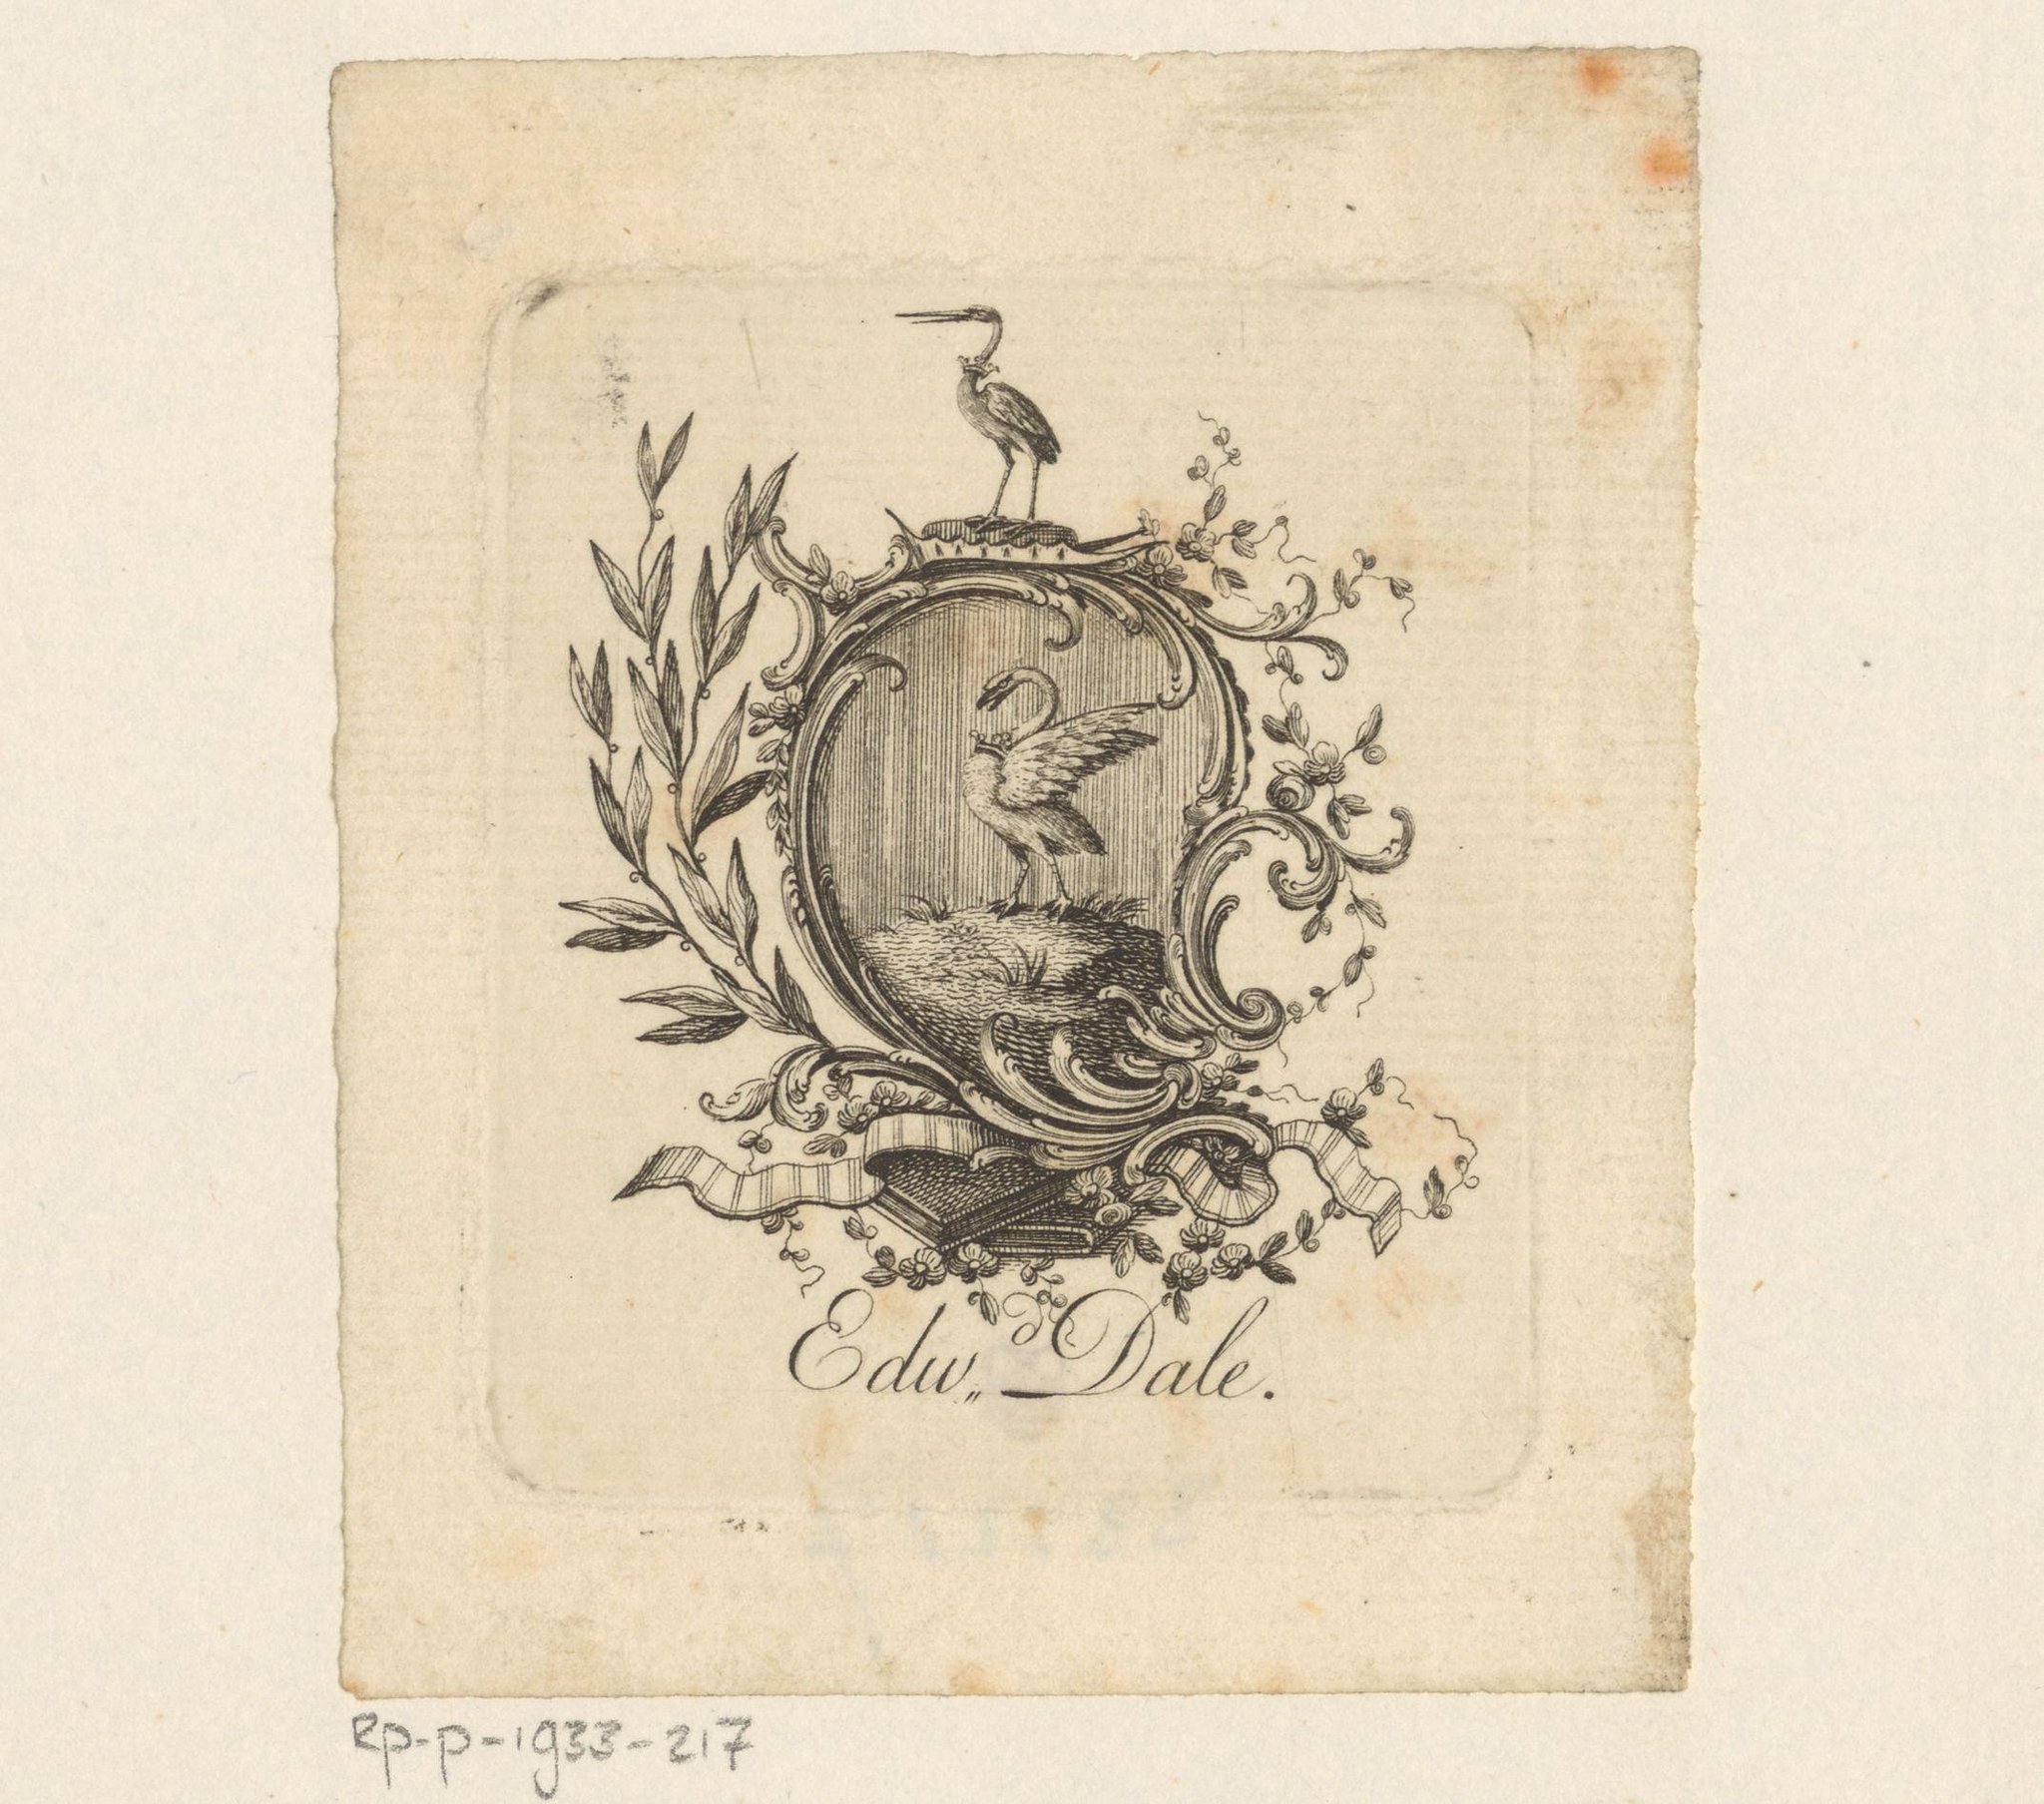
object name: bookplate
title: Ex libris van Edw. Dale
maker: Anonymous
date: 1750-1780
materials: paper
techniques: etching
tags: armorial bearing, heraldry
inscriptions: collector's mark: Lugt 2760